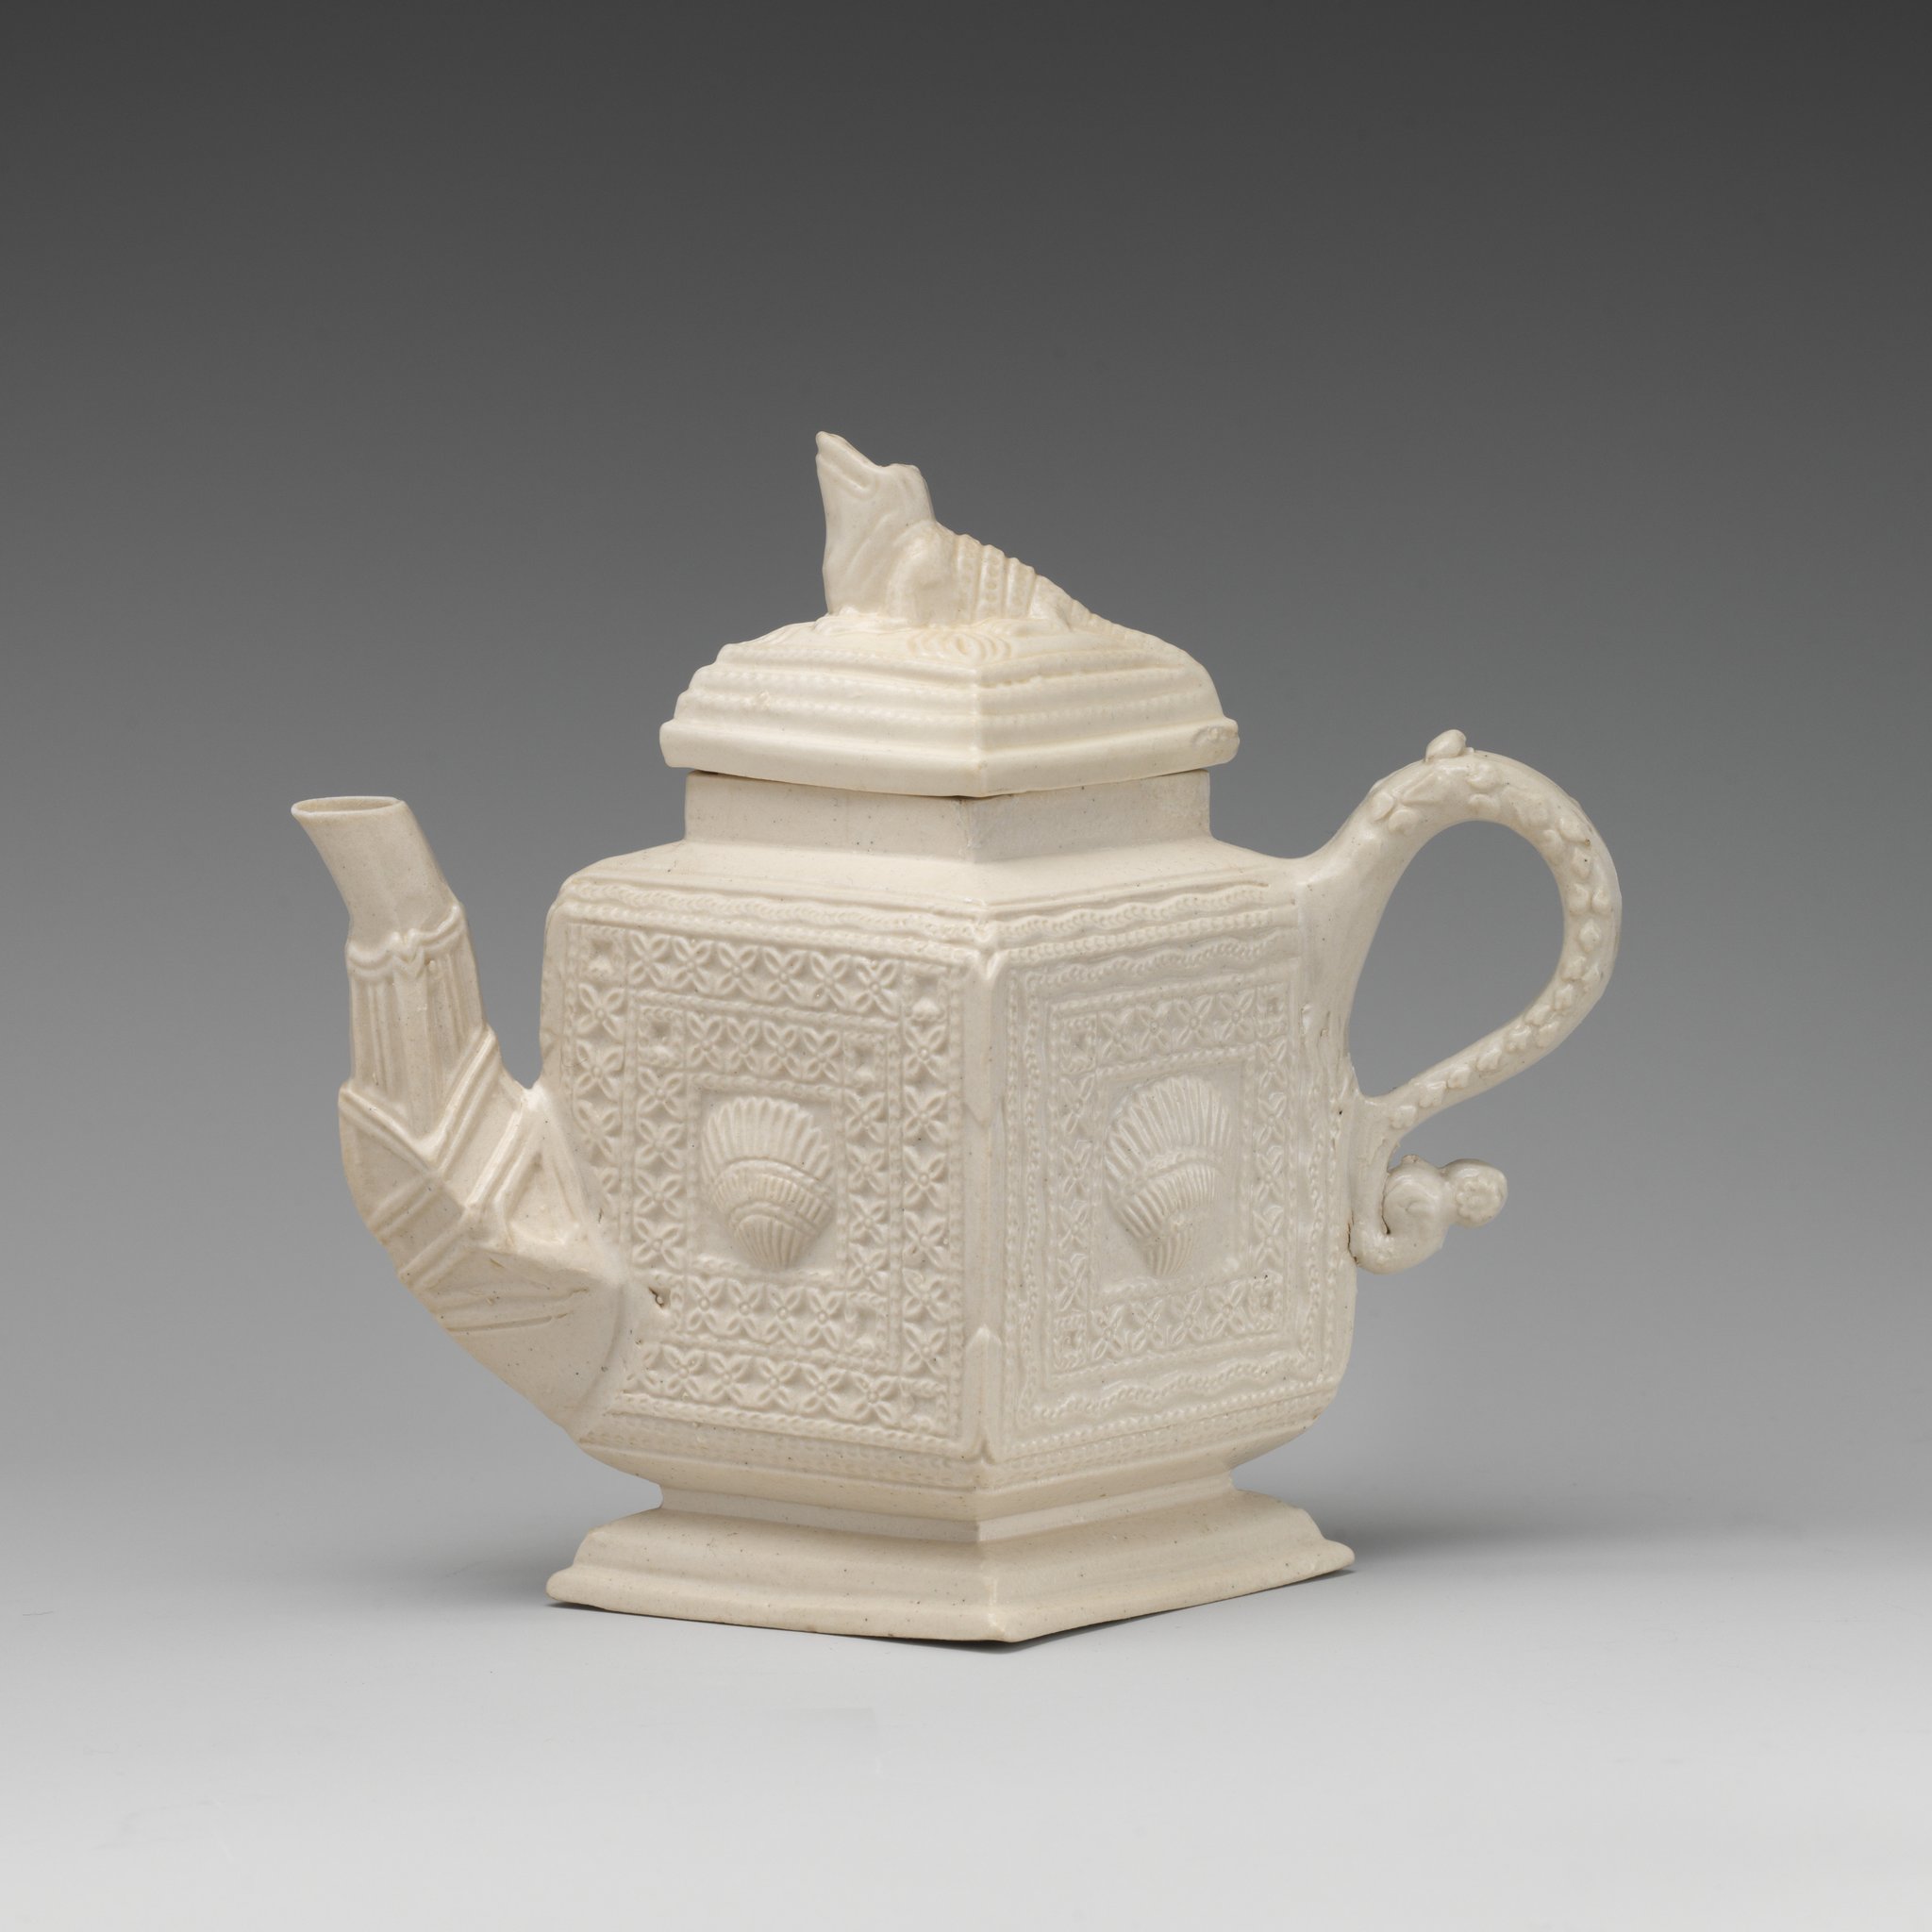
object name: teapot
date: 1745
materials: stoneware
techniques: salt glaze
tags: shells